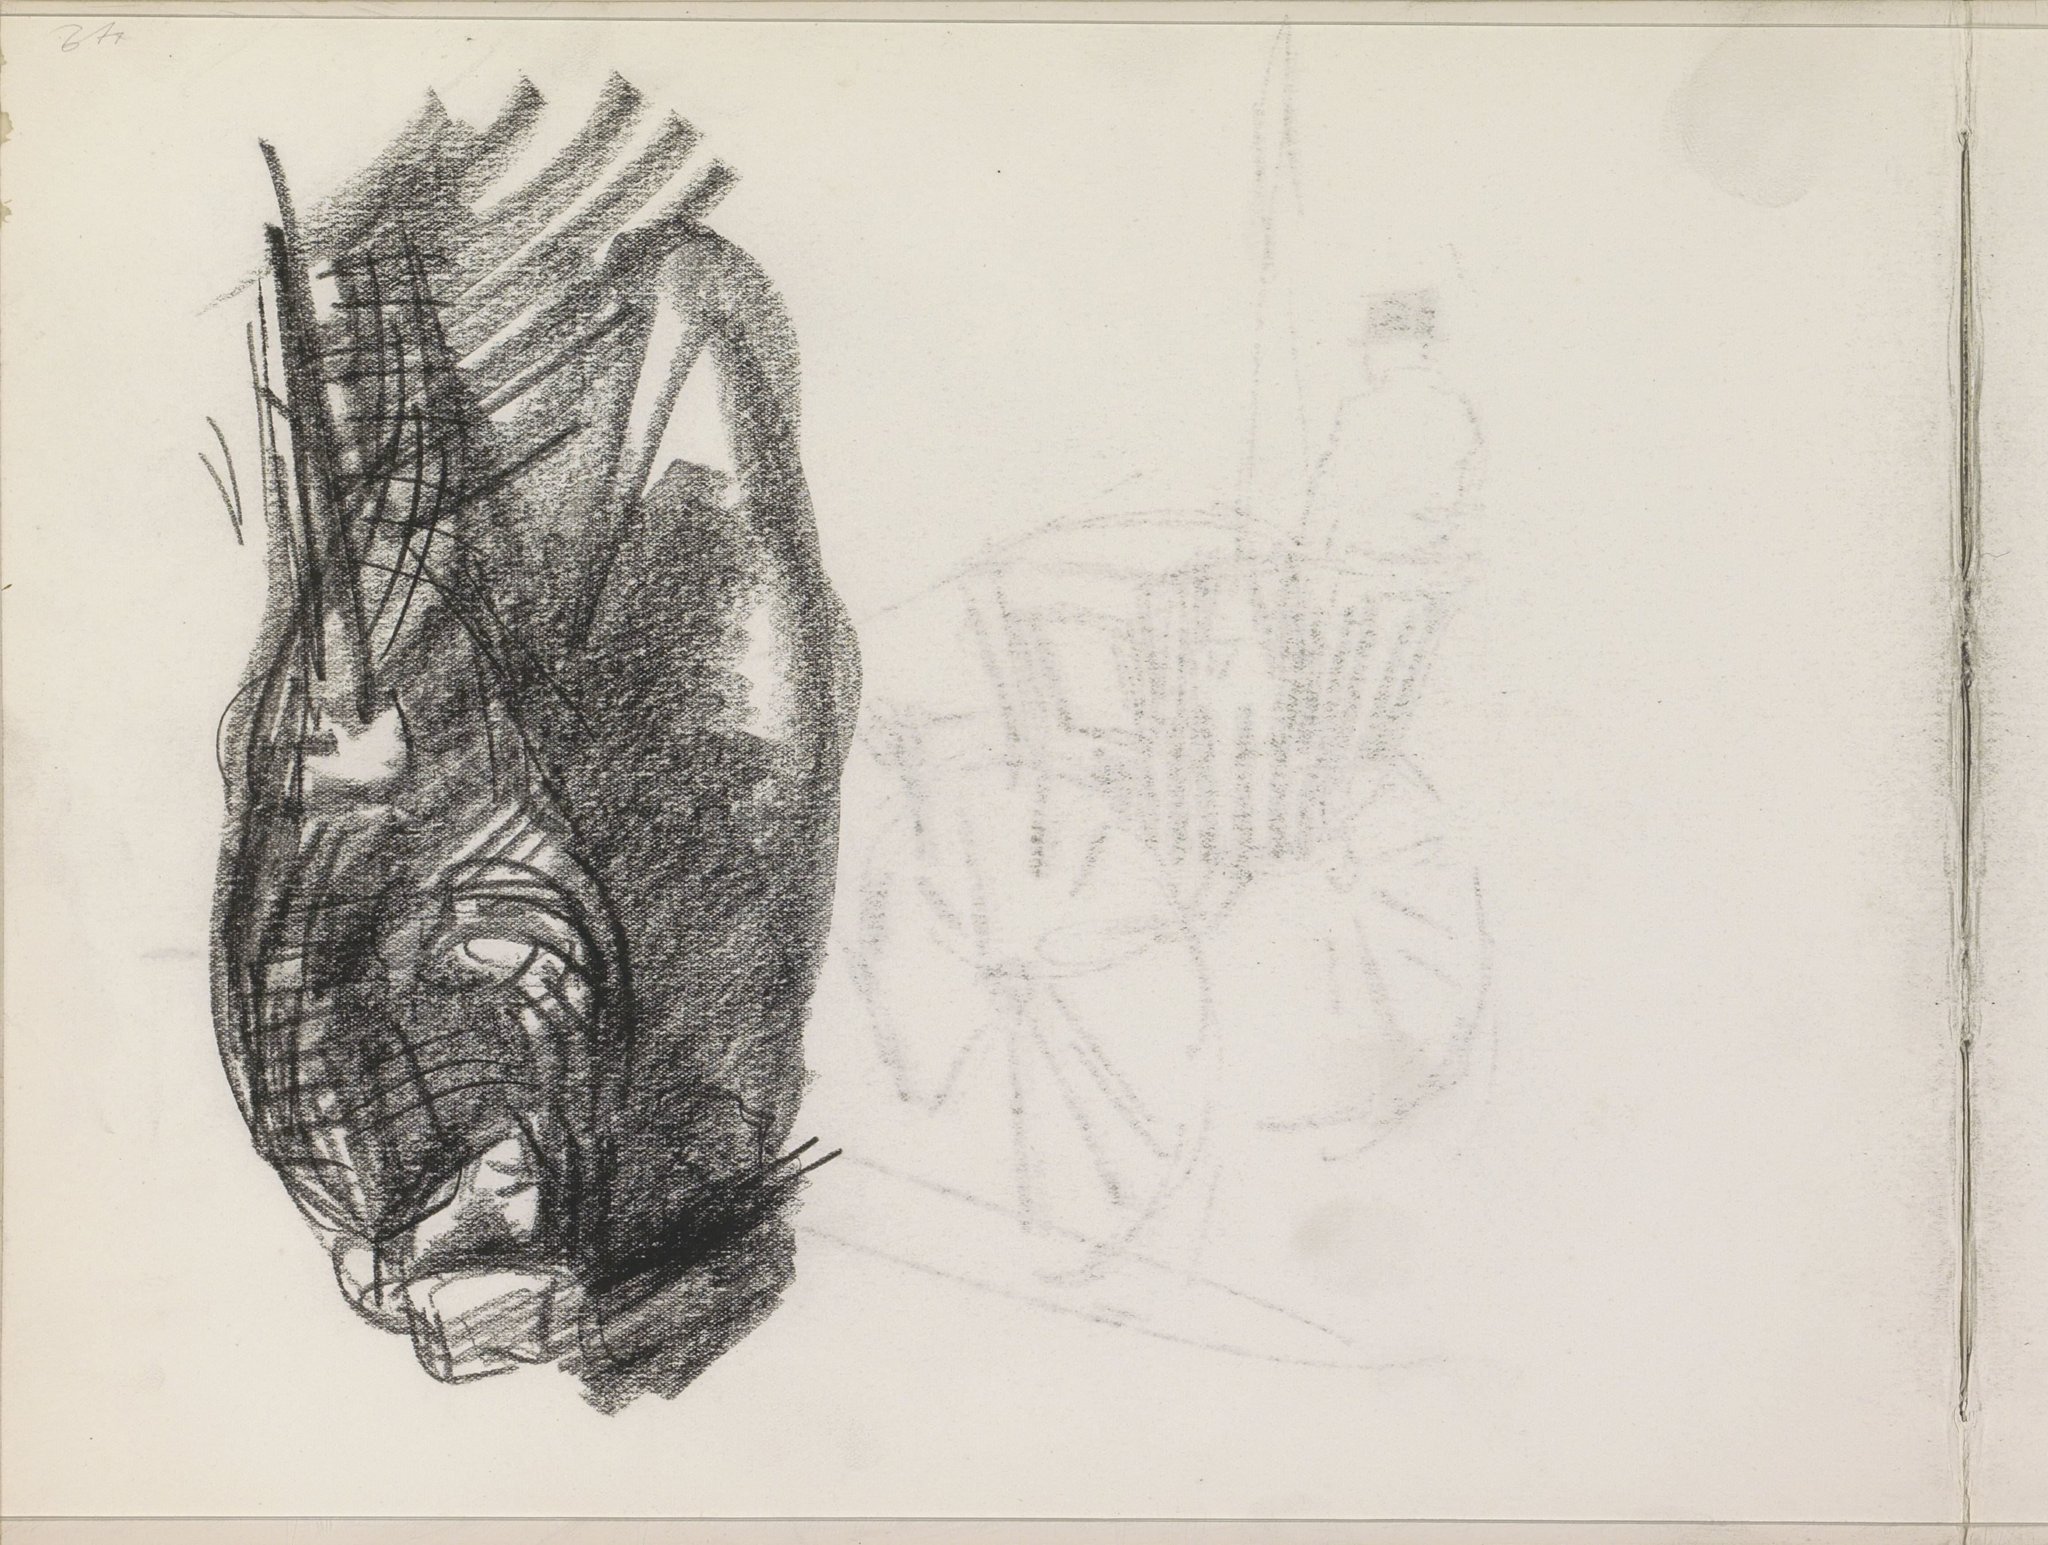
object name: sketchbook leaf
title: Oude man met stok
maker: isaac israels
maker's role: draughtsman, painter, print maker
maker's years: 1865-1934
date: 1875-1934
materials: chalk, paper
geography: the hague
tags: old man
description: Blad 11 verso uit schetsboek VII met 26 bladen.